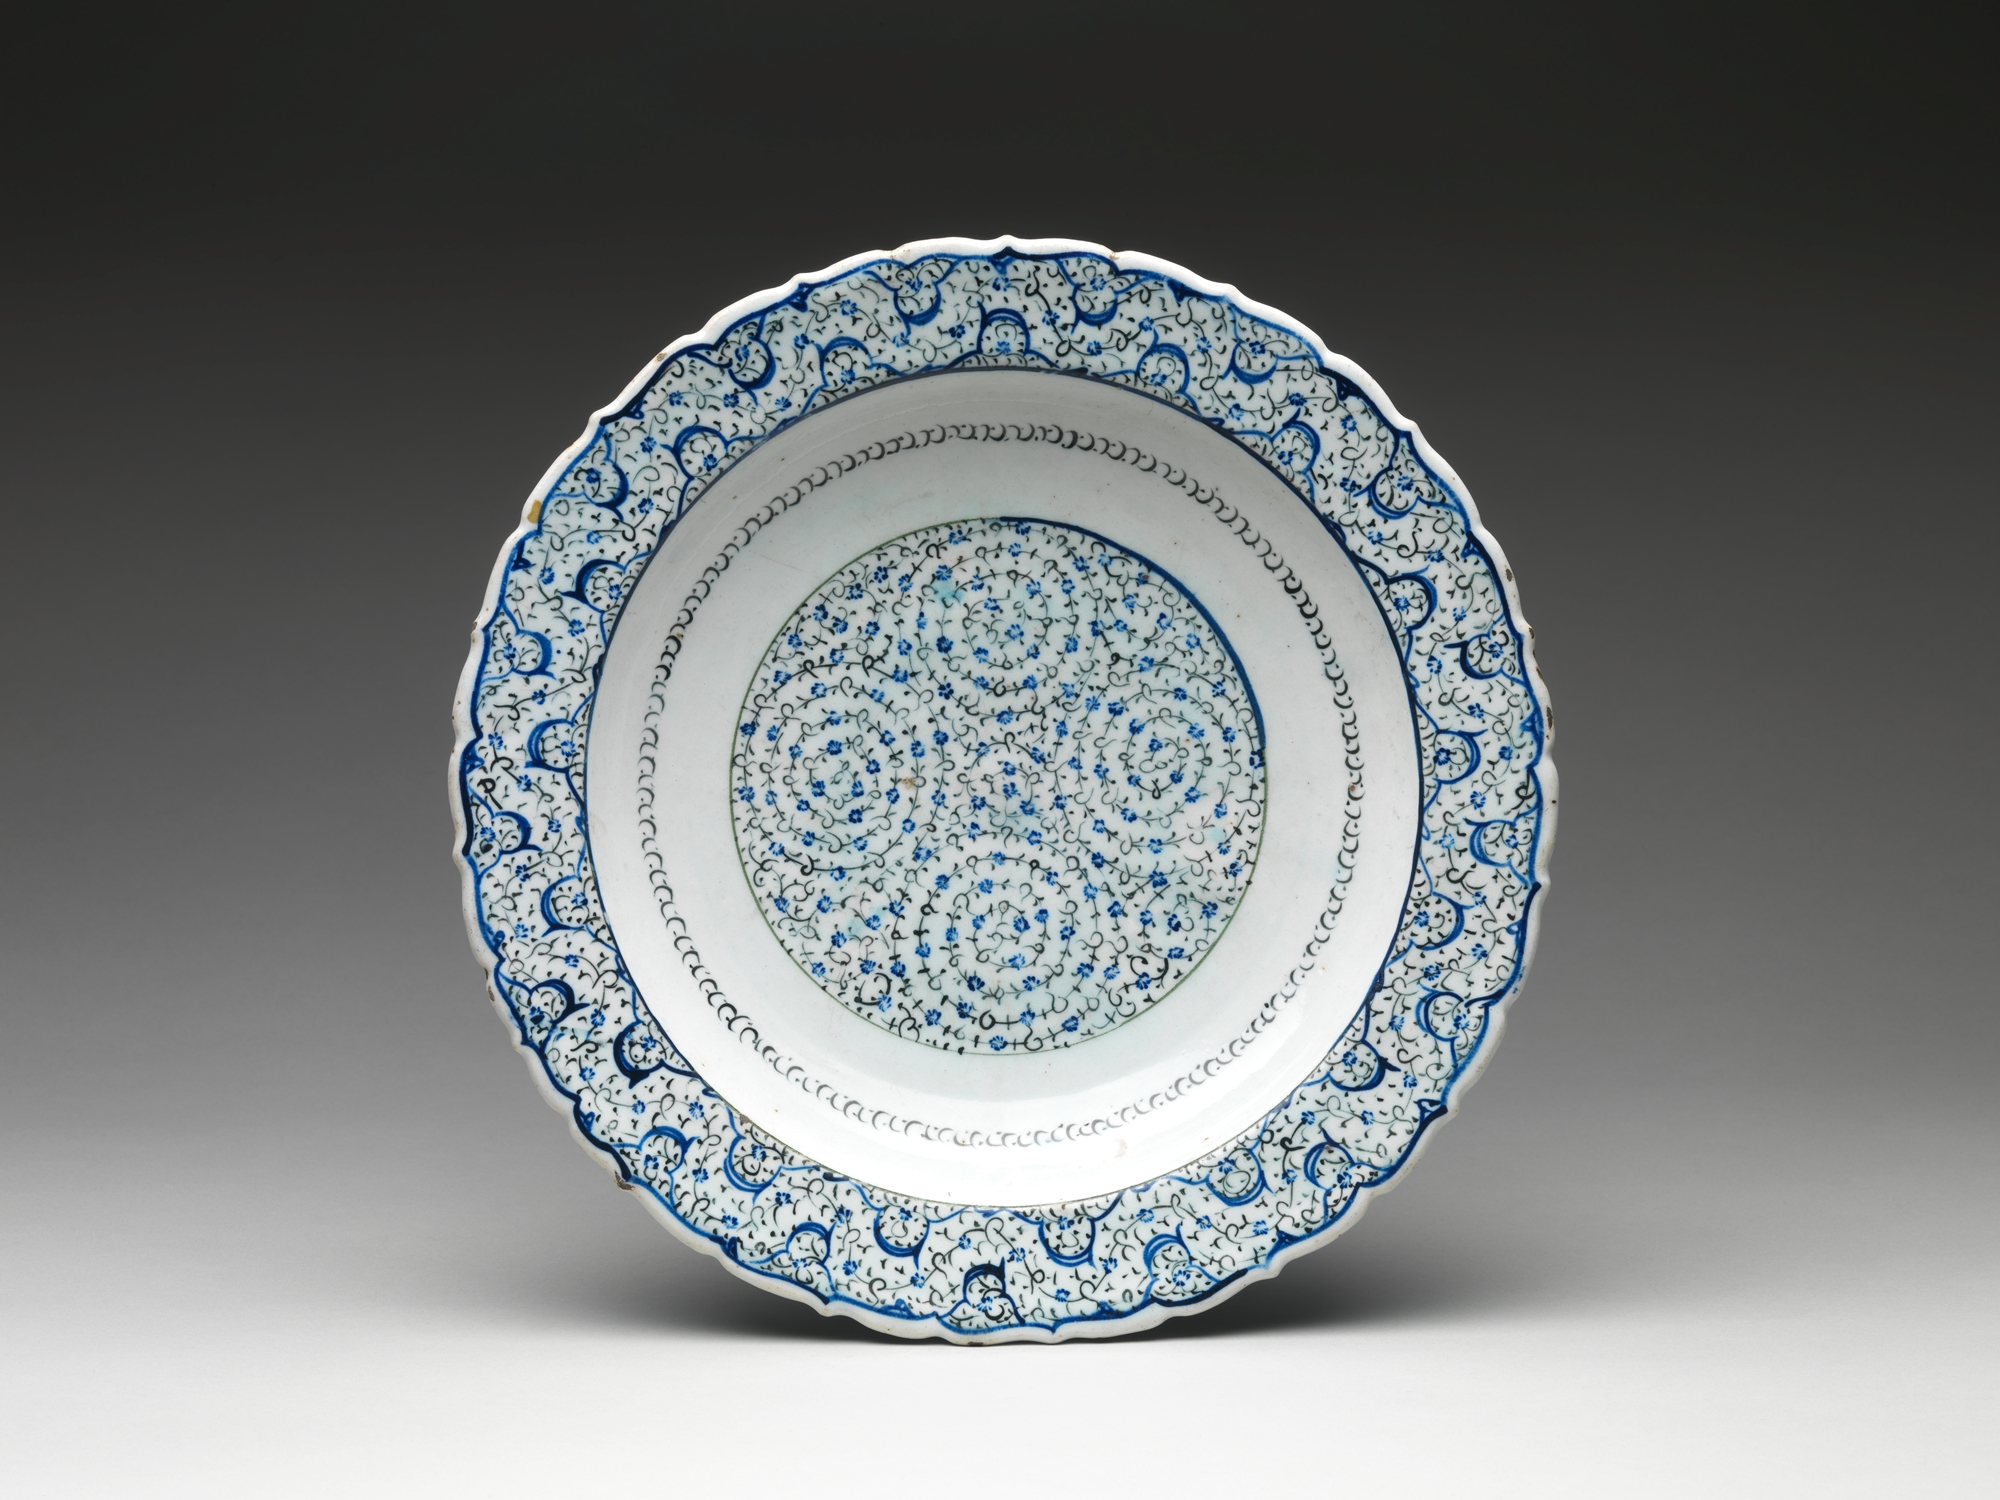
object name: plate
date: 1501-1550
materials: stonepaste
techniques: glazing, painting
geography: turkey